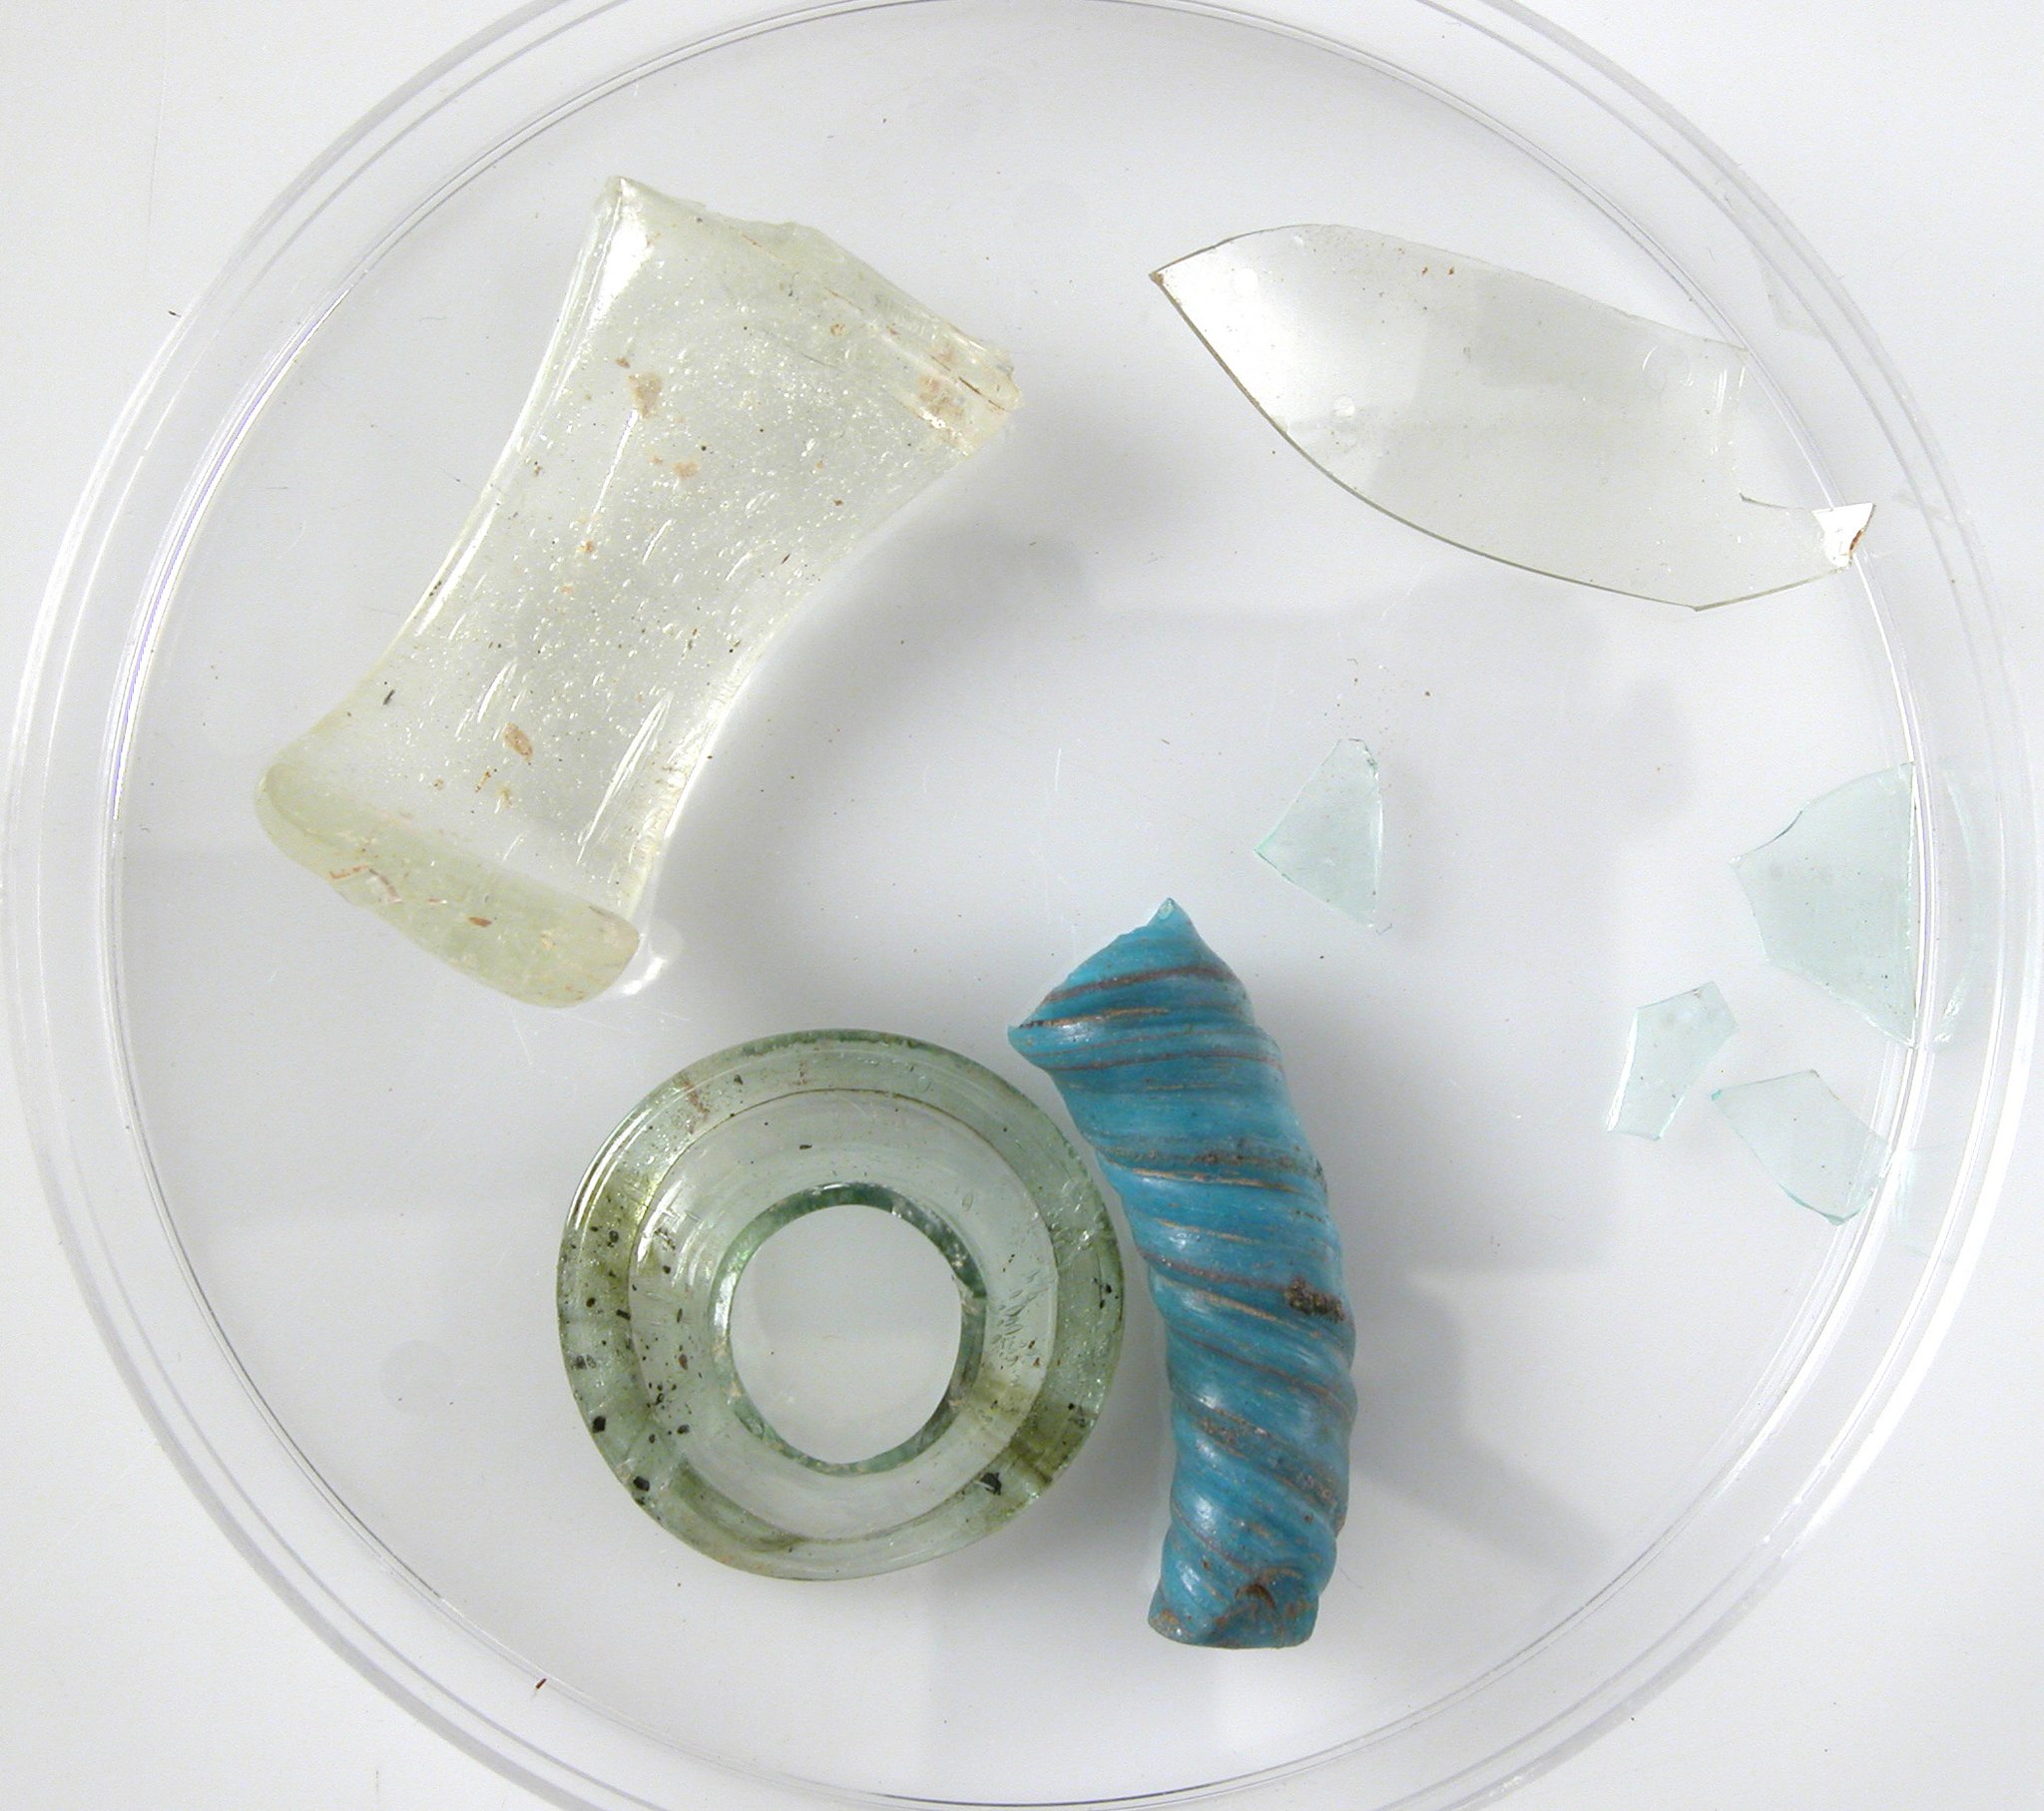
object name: fragment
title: Glass Fragments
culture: coptic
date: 301-700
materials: glass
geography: egypt